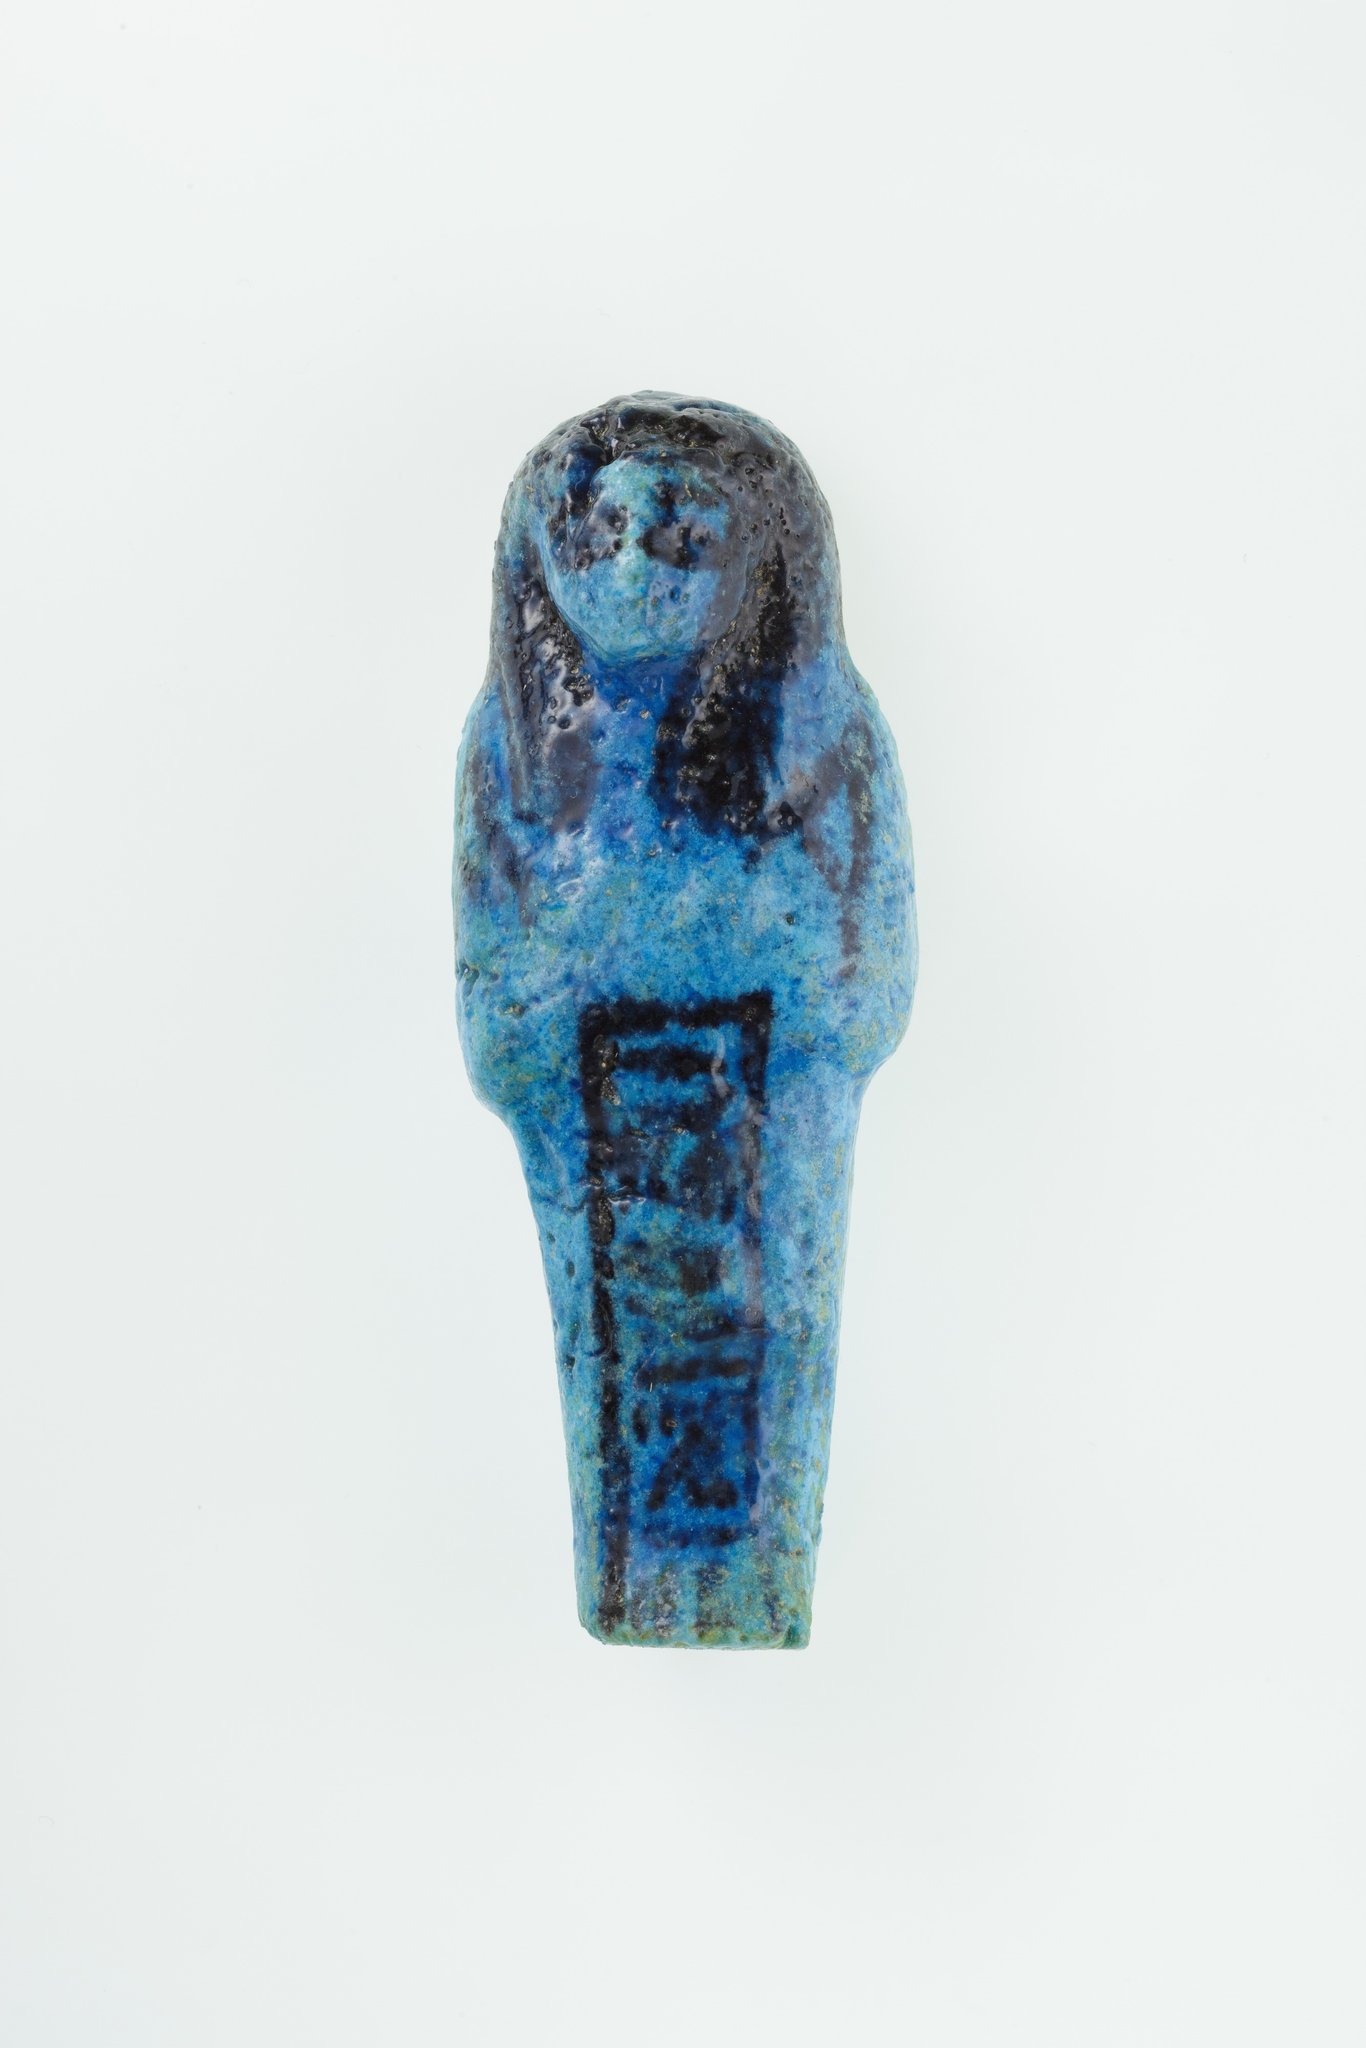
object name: shabti, worker, nauny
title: Worker Shabti of Nauny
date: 1050 BCE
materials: faience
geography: egypt